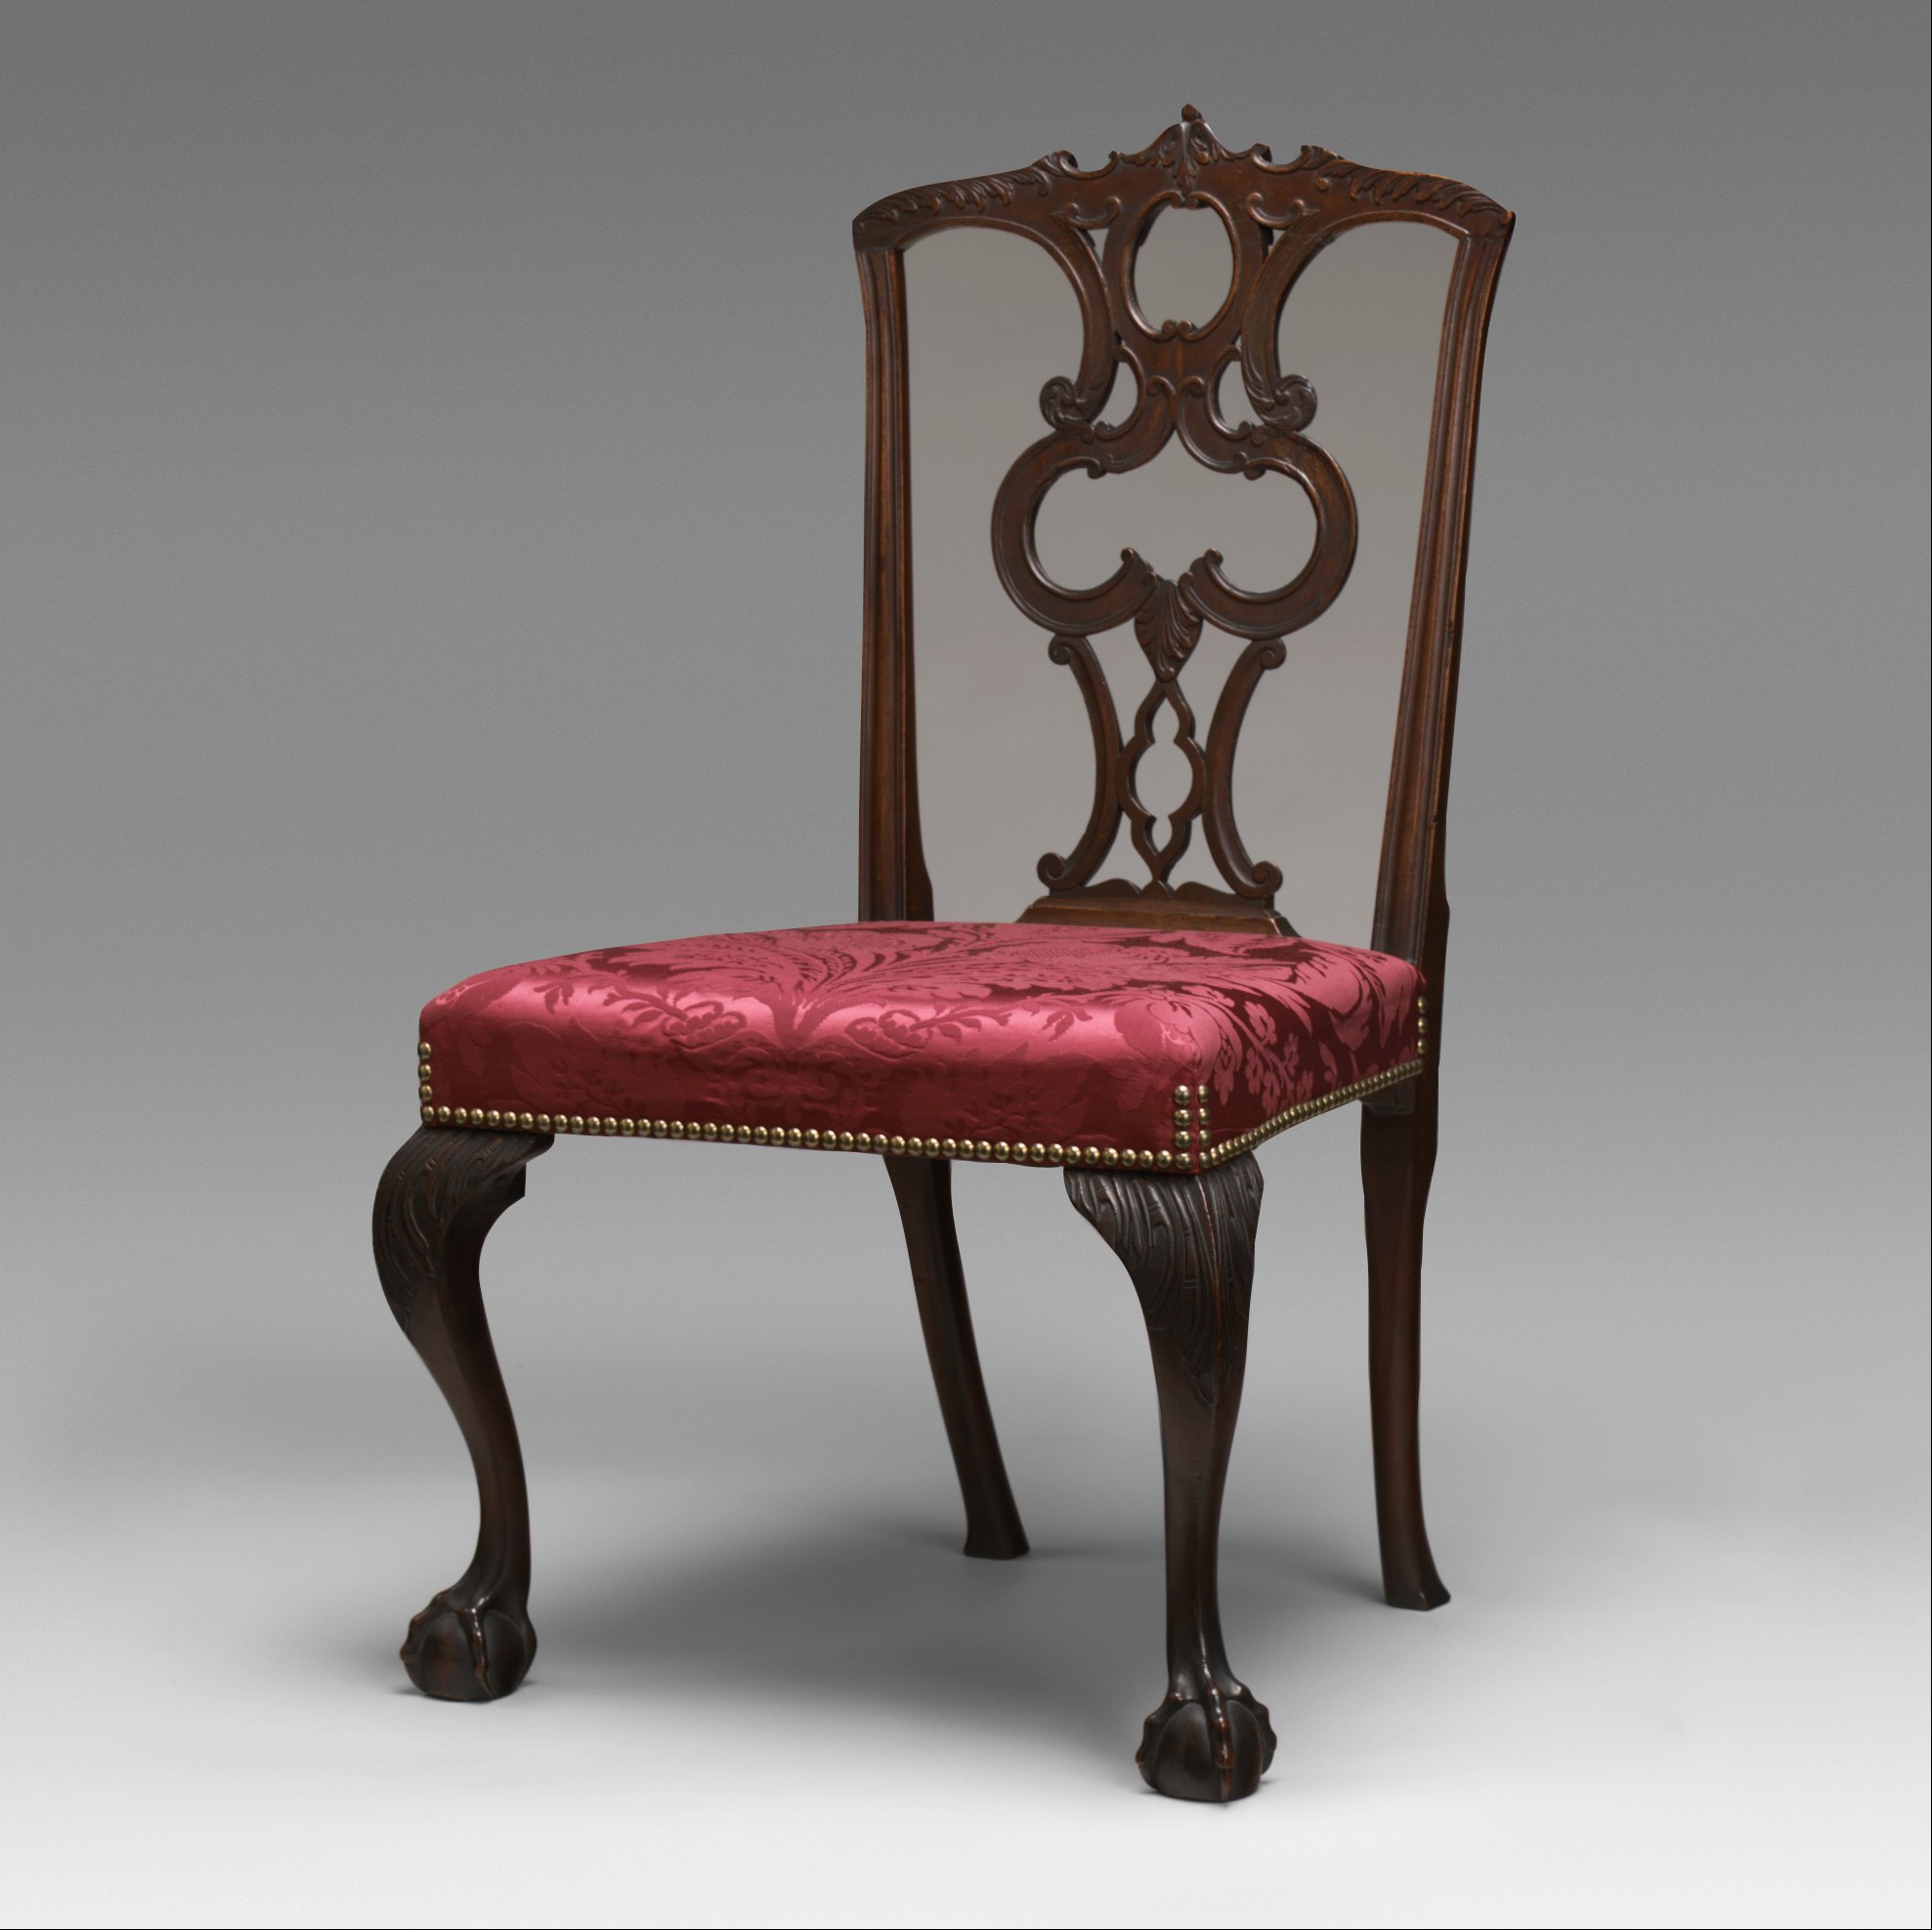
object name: side chair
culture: american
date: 1765-1790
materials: wood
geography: united states